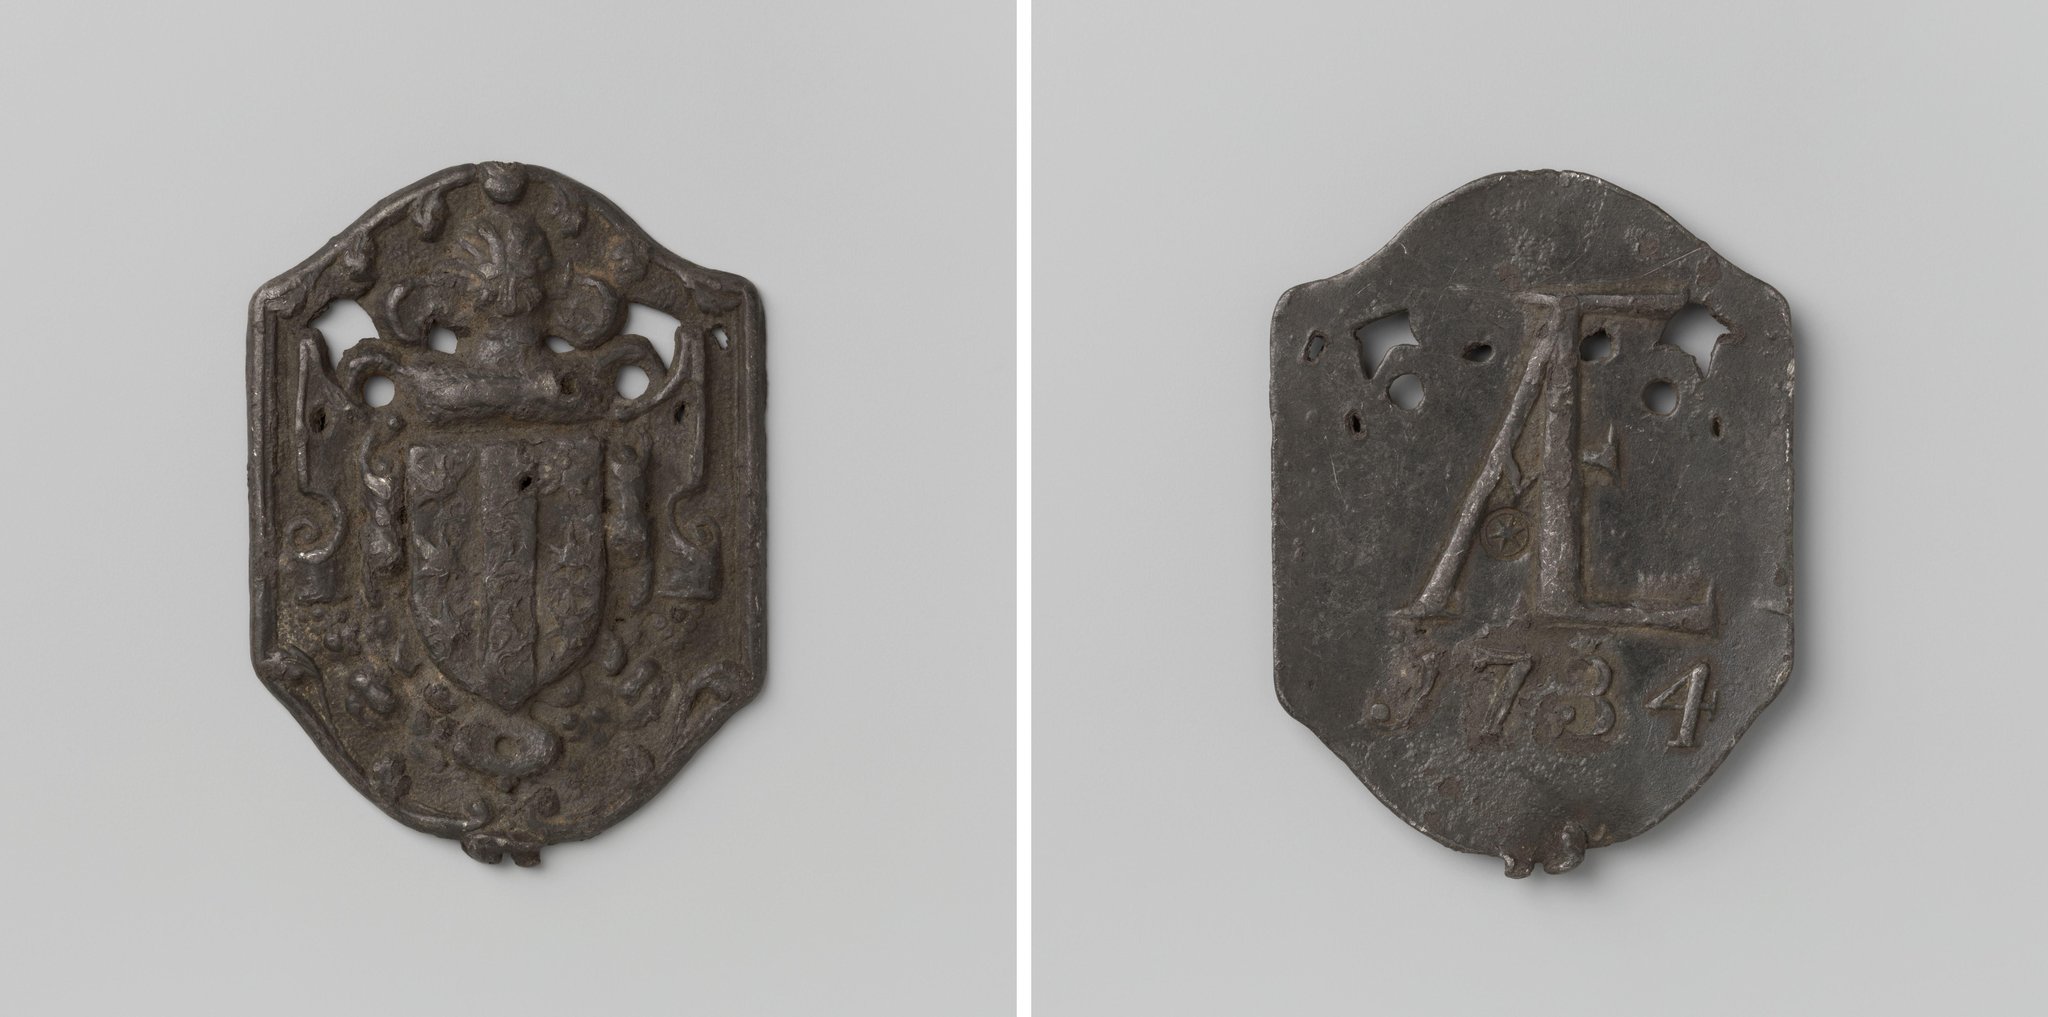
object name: turfloodje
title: Stad Gouda, loodje goed voor een ton turf en een gift in geld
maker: Anonymous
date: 1734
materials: lead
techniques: casting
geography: gouda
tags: gouda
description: penning van onregelmatige vorm. Voorzijde: wapenschild in sierlijk cartouche. Keerzijde: monogram van letters A en E boven jaartal; tussen letters A en E klop: zespuntige ster